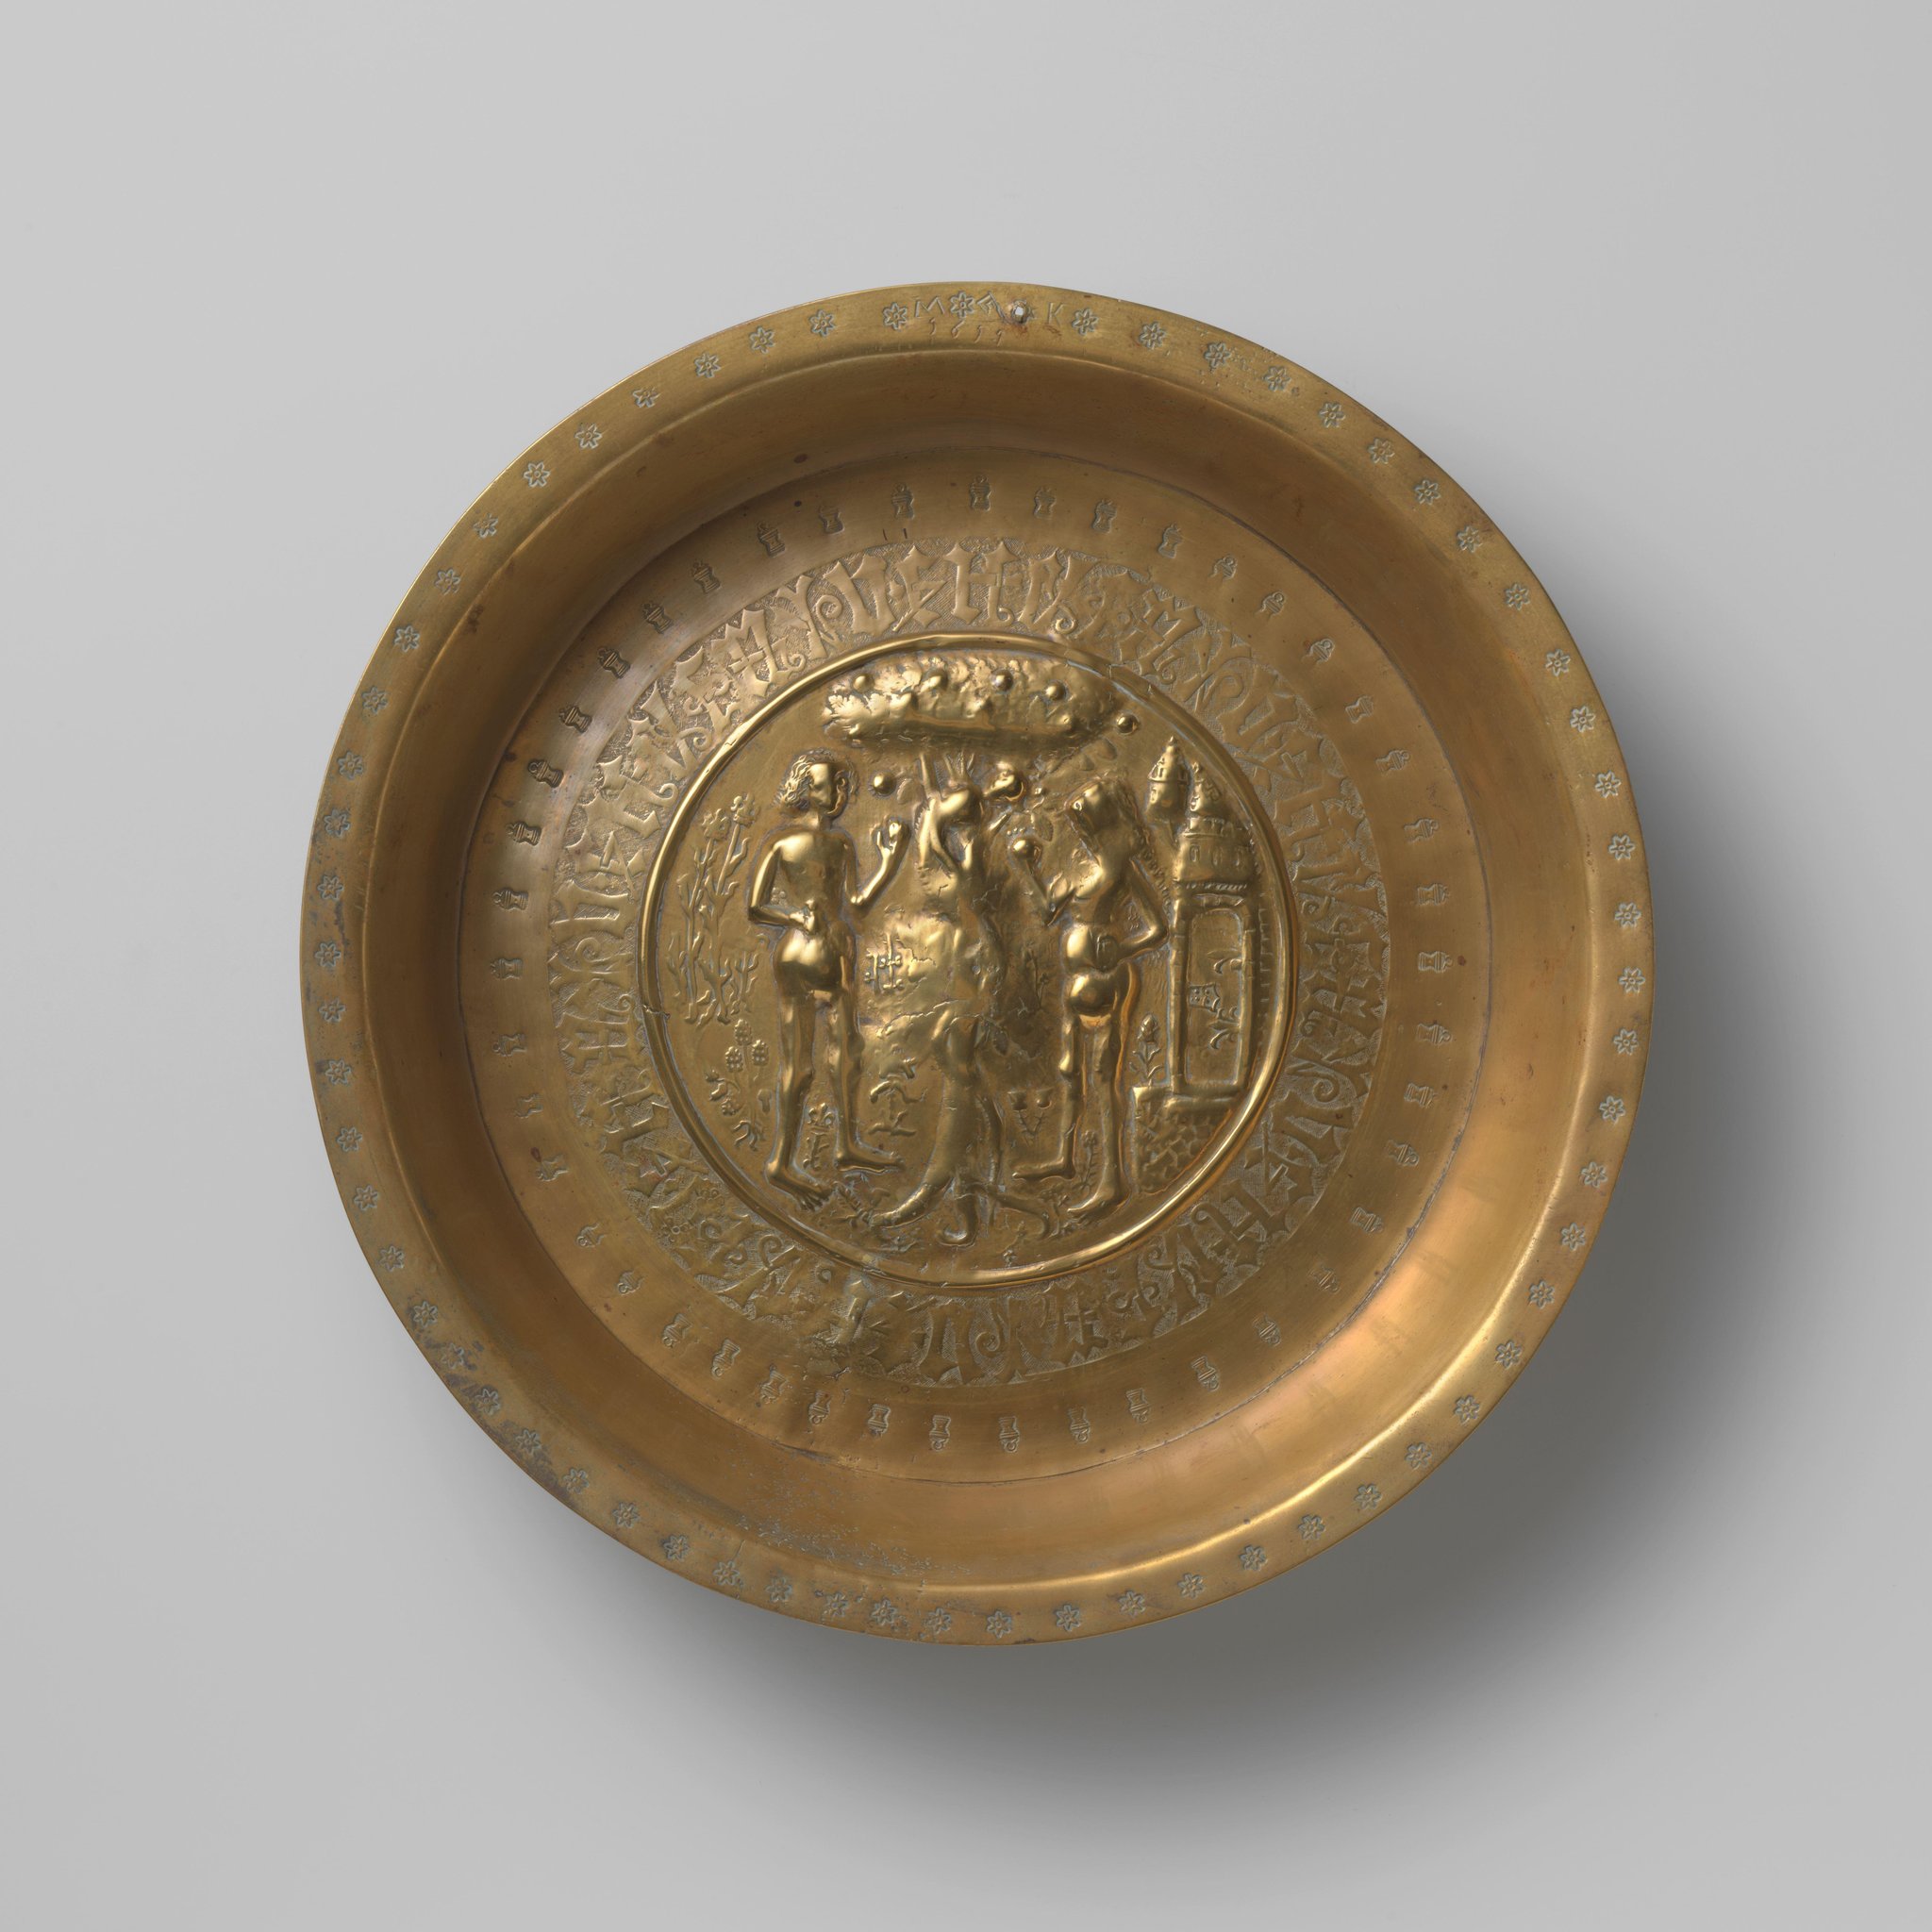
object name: bekken schaal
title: Bekken met Adam en Eva en het jaartal 1611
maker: Anonymous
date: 1500-1600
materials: brass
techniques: casting, metalworking, engraving, punching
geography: nuremberg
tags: eve offers the fruit to adam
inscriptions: inscription: ‘MK 1611’, maker's mark, inscription: ‘ART AL ZEIT GELUEK (vier maal)’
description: In het plat van de schotel, die in het midden het centerpunt heeft, zijn met behulp van stempelvormen geponst een voorstelling van Adam en Eva in het Paradijs (Genesis 3, 1-8) en een stuk rand met de tekst ART AL ZEIT GELUEK op gearceerde achtergrond, dat vier maal is herhaald. Om de letterrand is een geponst ornament aangebracht met als motief een wijwateremmer. Op de boord zijn rozetten geponst, zijn het huismerk en het jaartal gegraveerd en is een gaatje geboord.